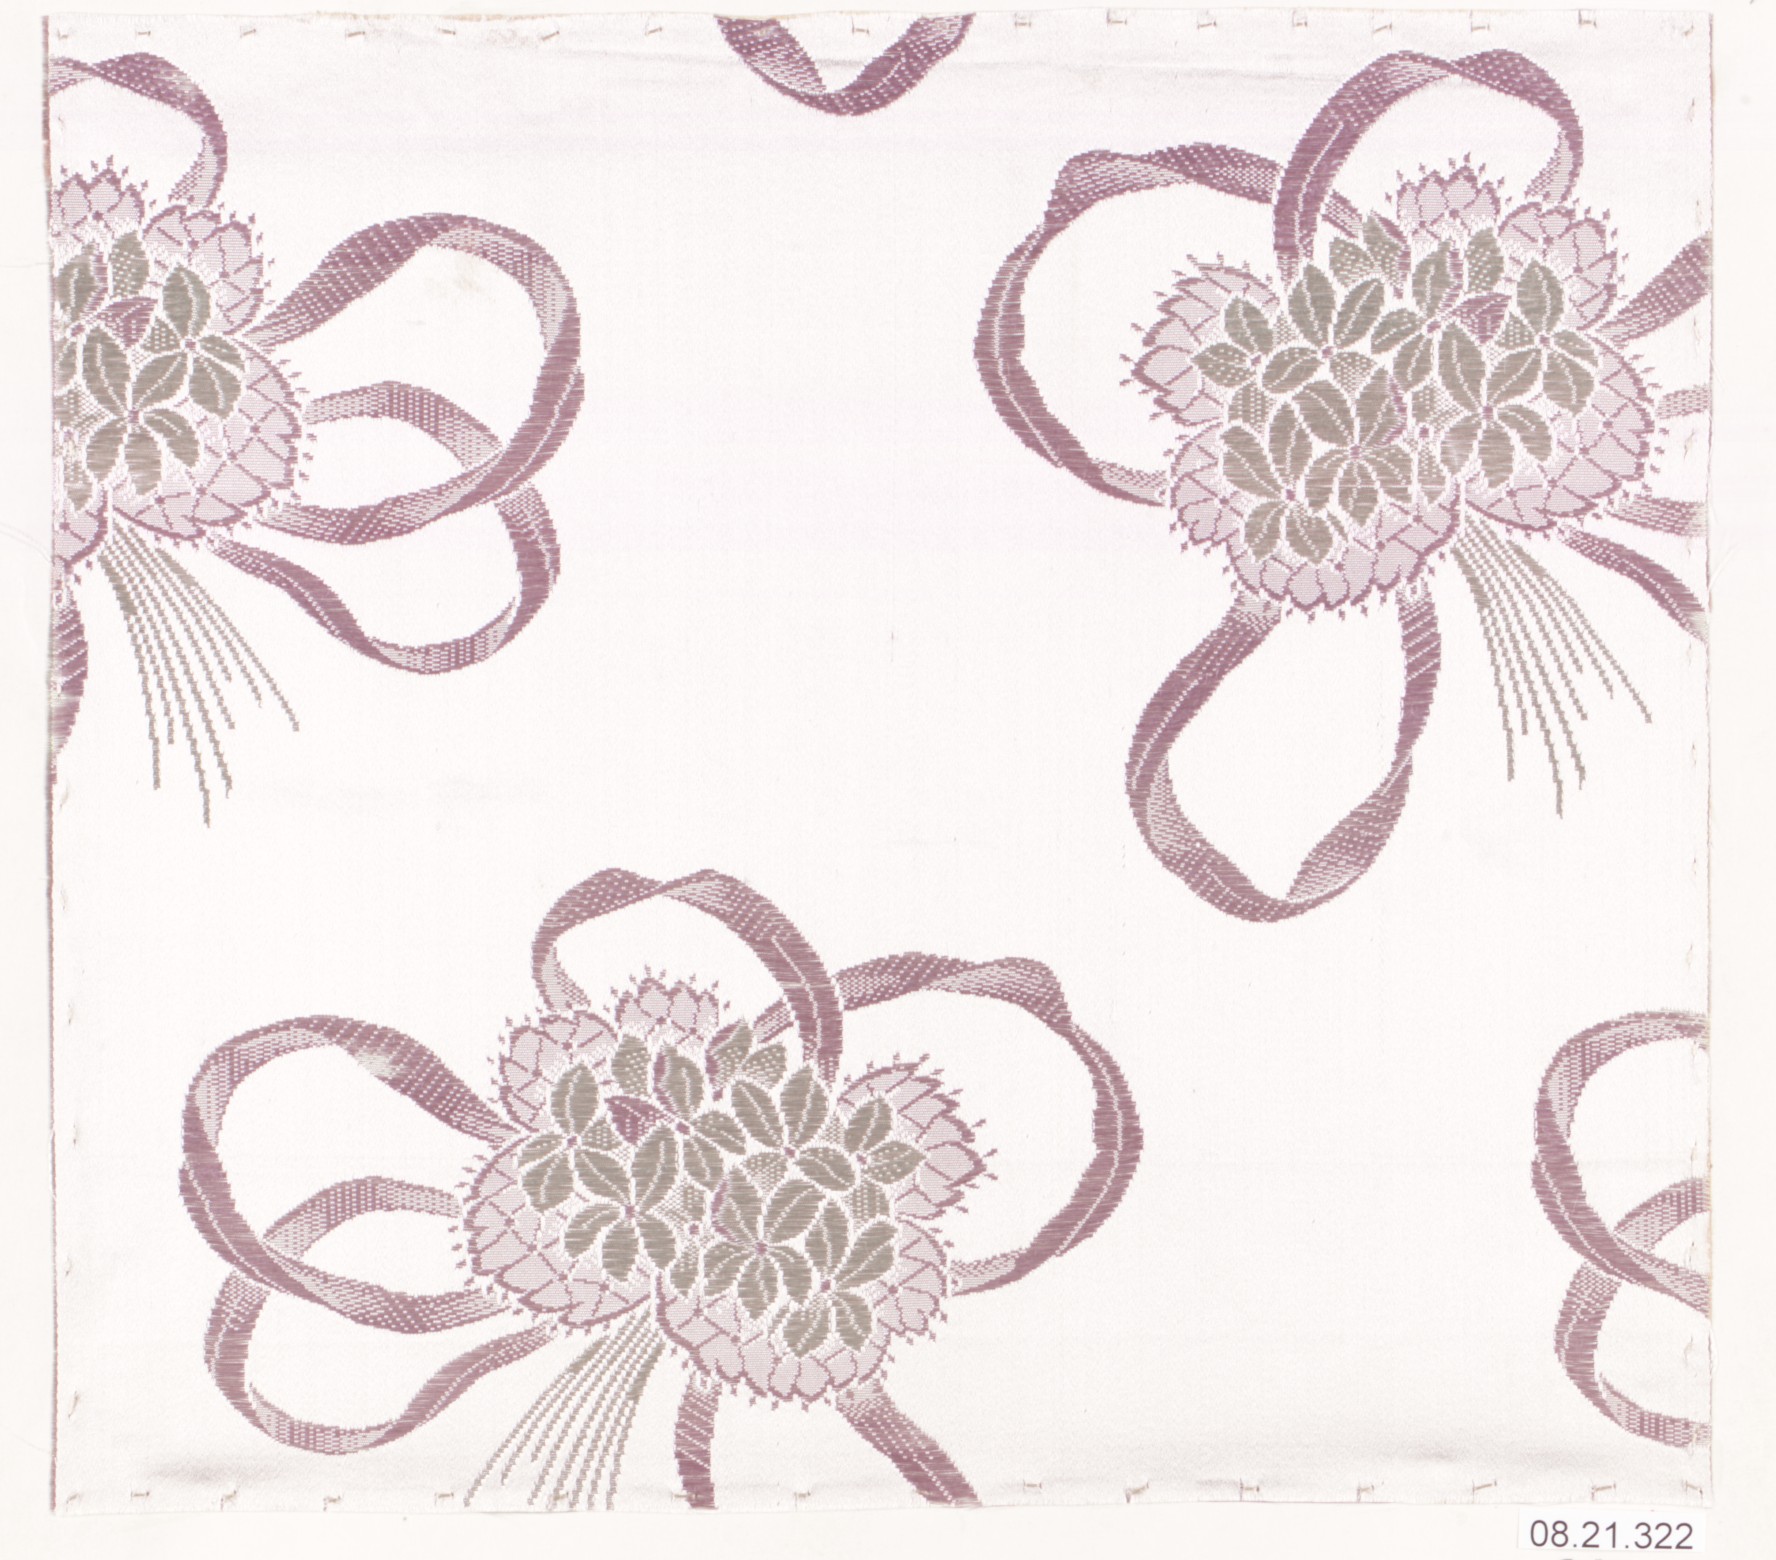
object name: textile sample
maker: Anonymous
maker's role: designer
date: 1900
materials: silk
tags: flowers